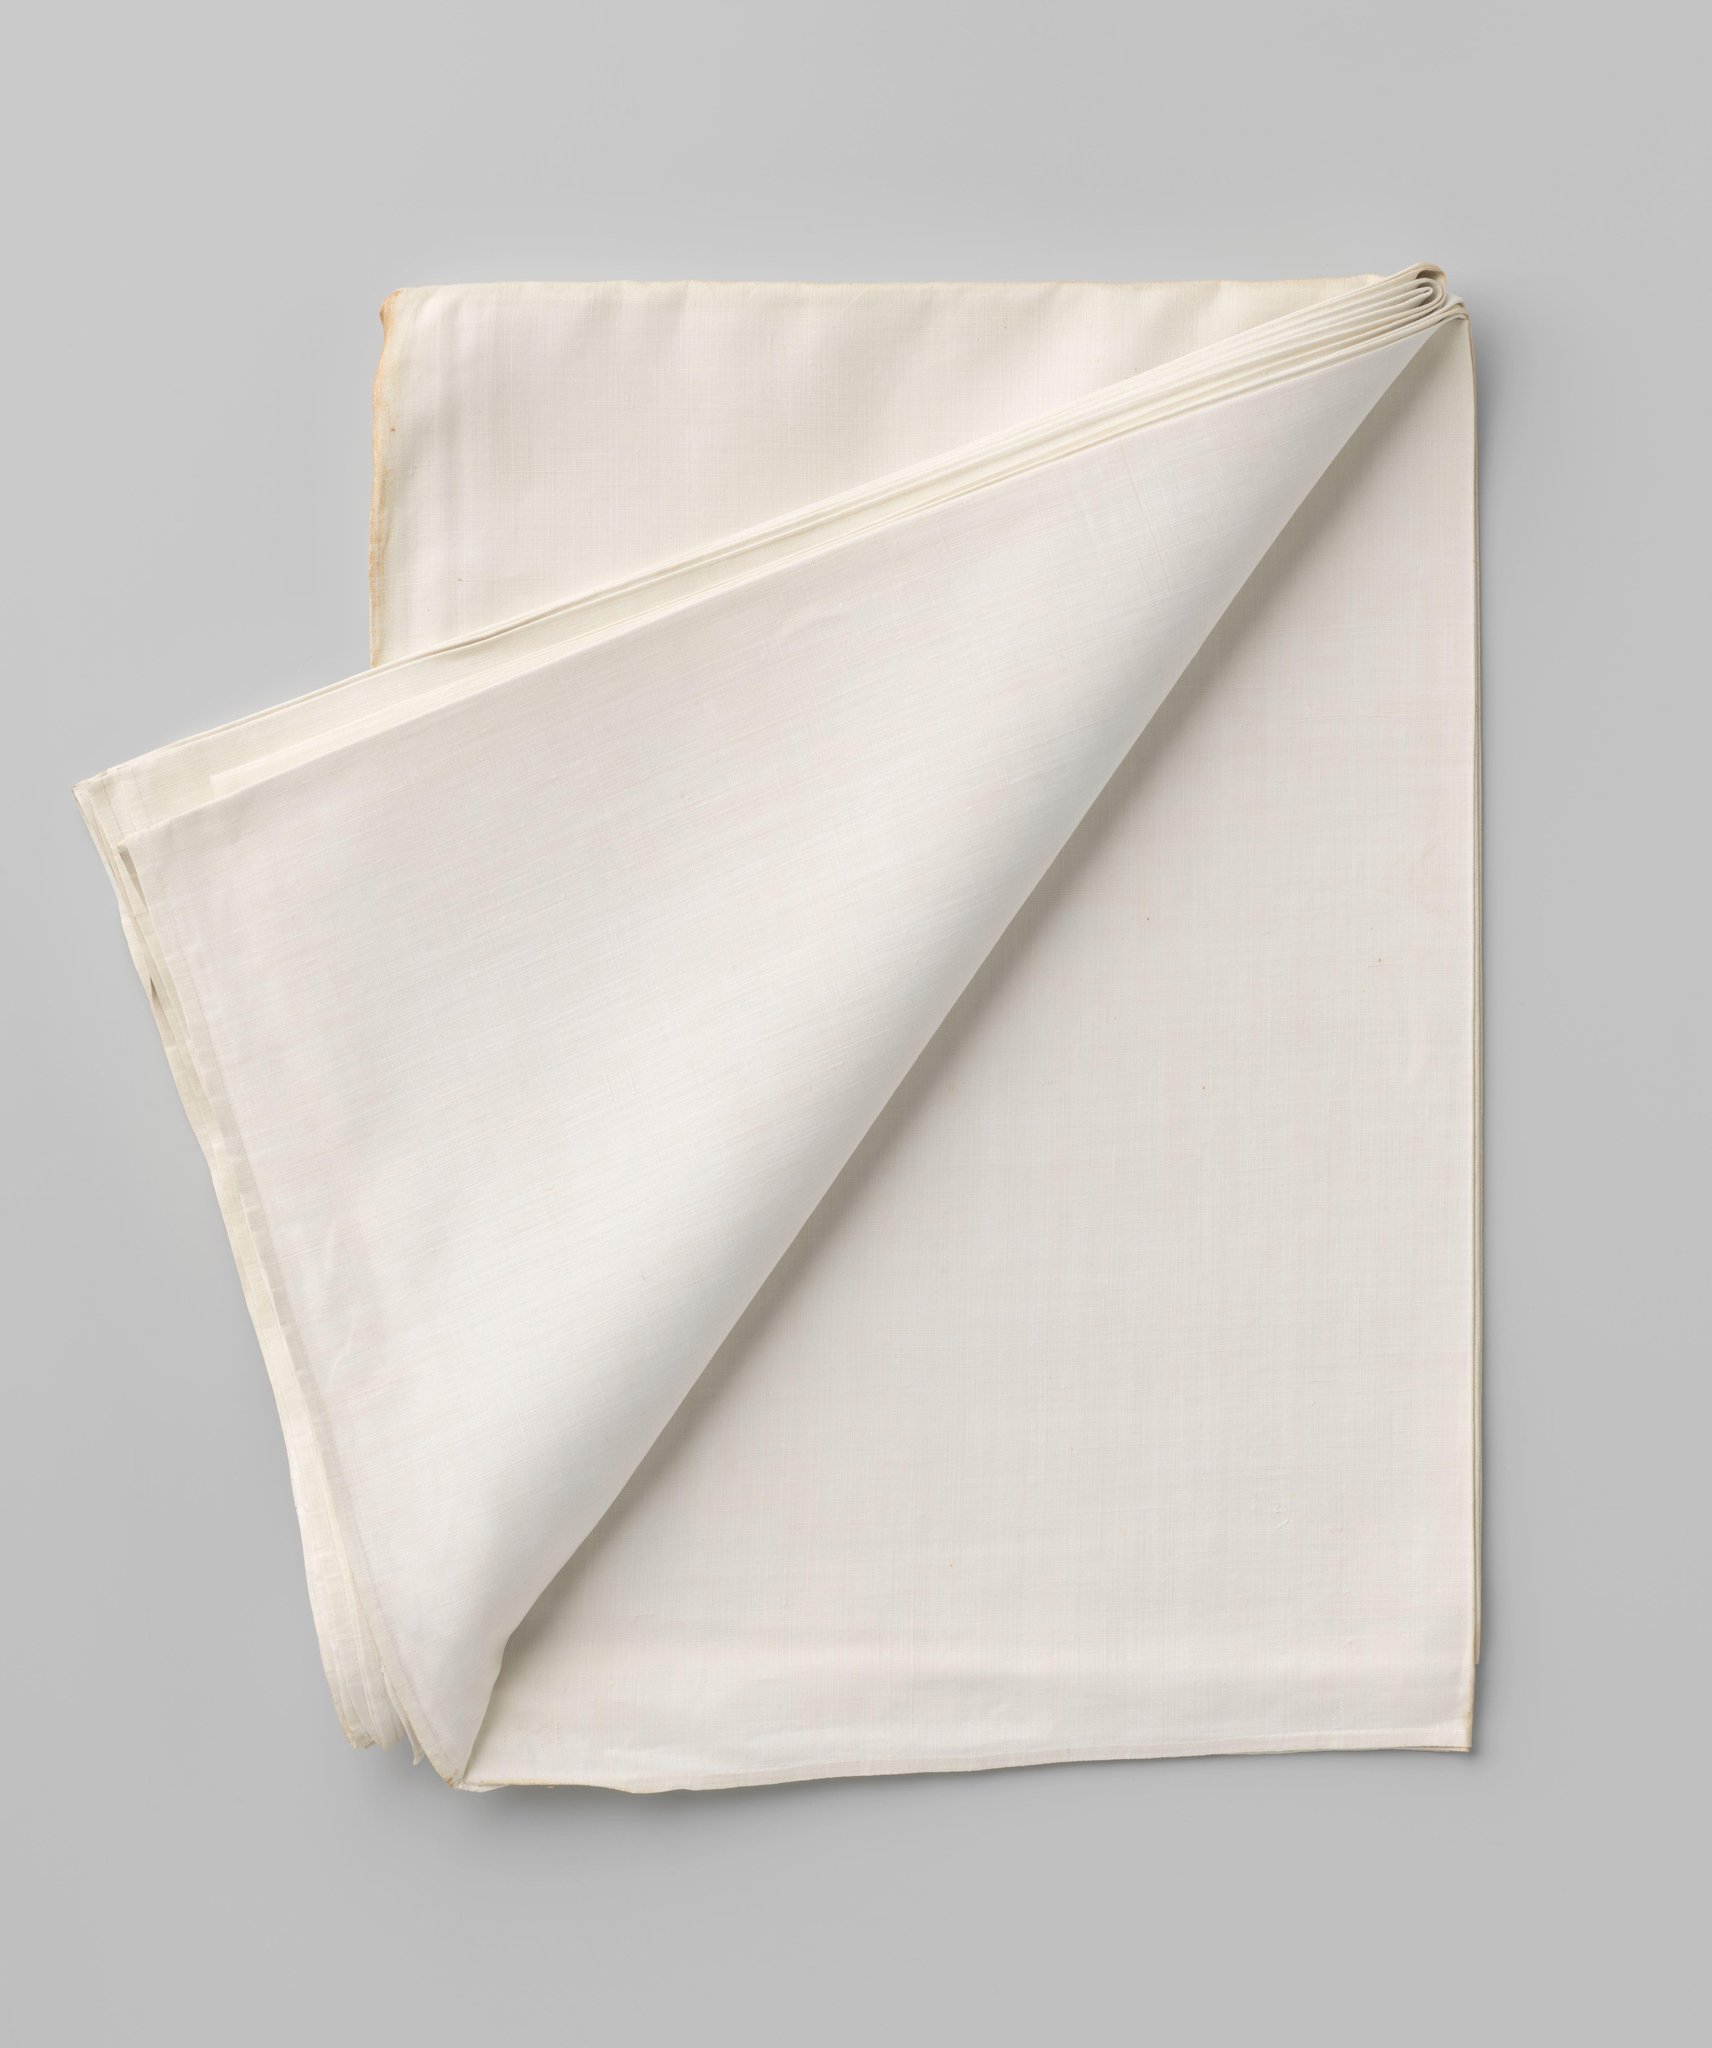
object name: beddenlaken, laken object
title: Laken. Merk: kroon WG en jaartal 1731.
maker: Anonymous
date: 1731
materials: linen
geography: northern netherlands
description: Laken van wit linnen, merk kroon WG en jaartal 1731